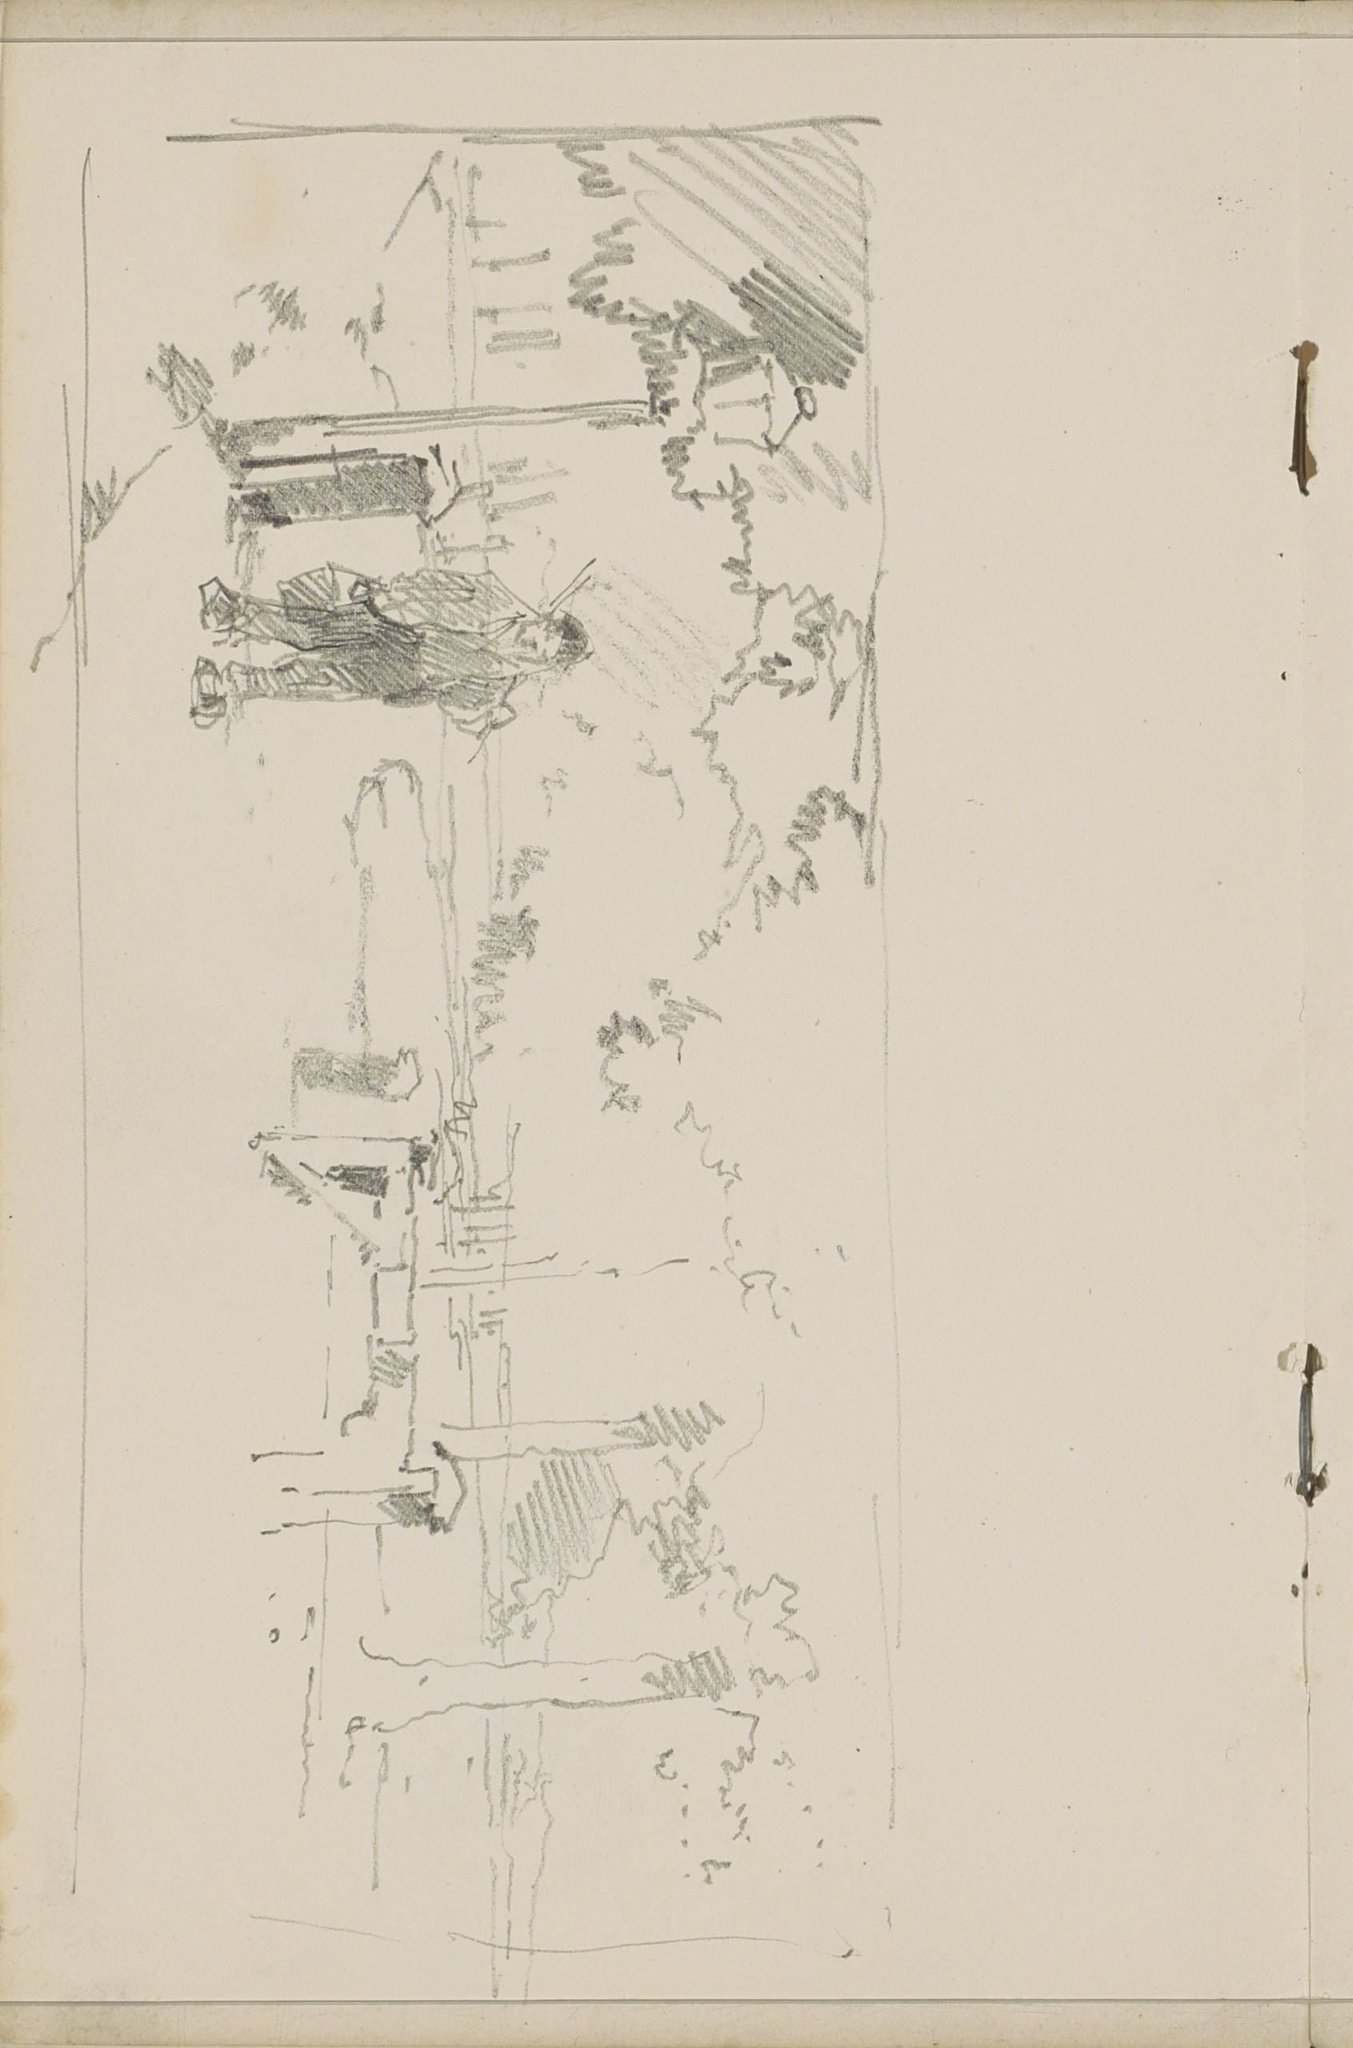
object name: sketchbook leaf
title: Wandelende man op een pad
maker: cornelis vreedenburgh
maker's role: draughtsman, print maker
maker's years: 1880-1946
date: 1890-1946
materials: paper, pencil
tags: road, path, walking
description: Langs het pad staan bomen en een lantarenpaal. De man draagt een emmer en houdt een stok op zijn schouder. Blad 36 verso uit een schetsboek met 47 bladen.